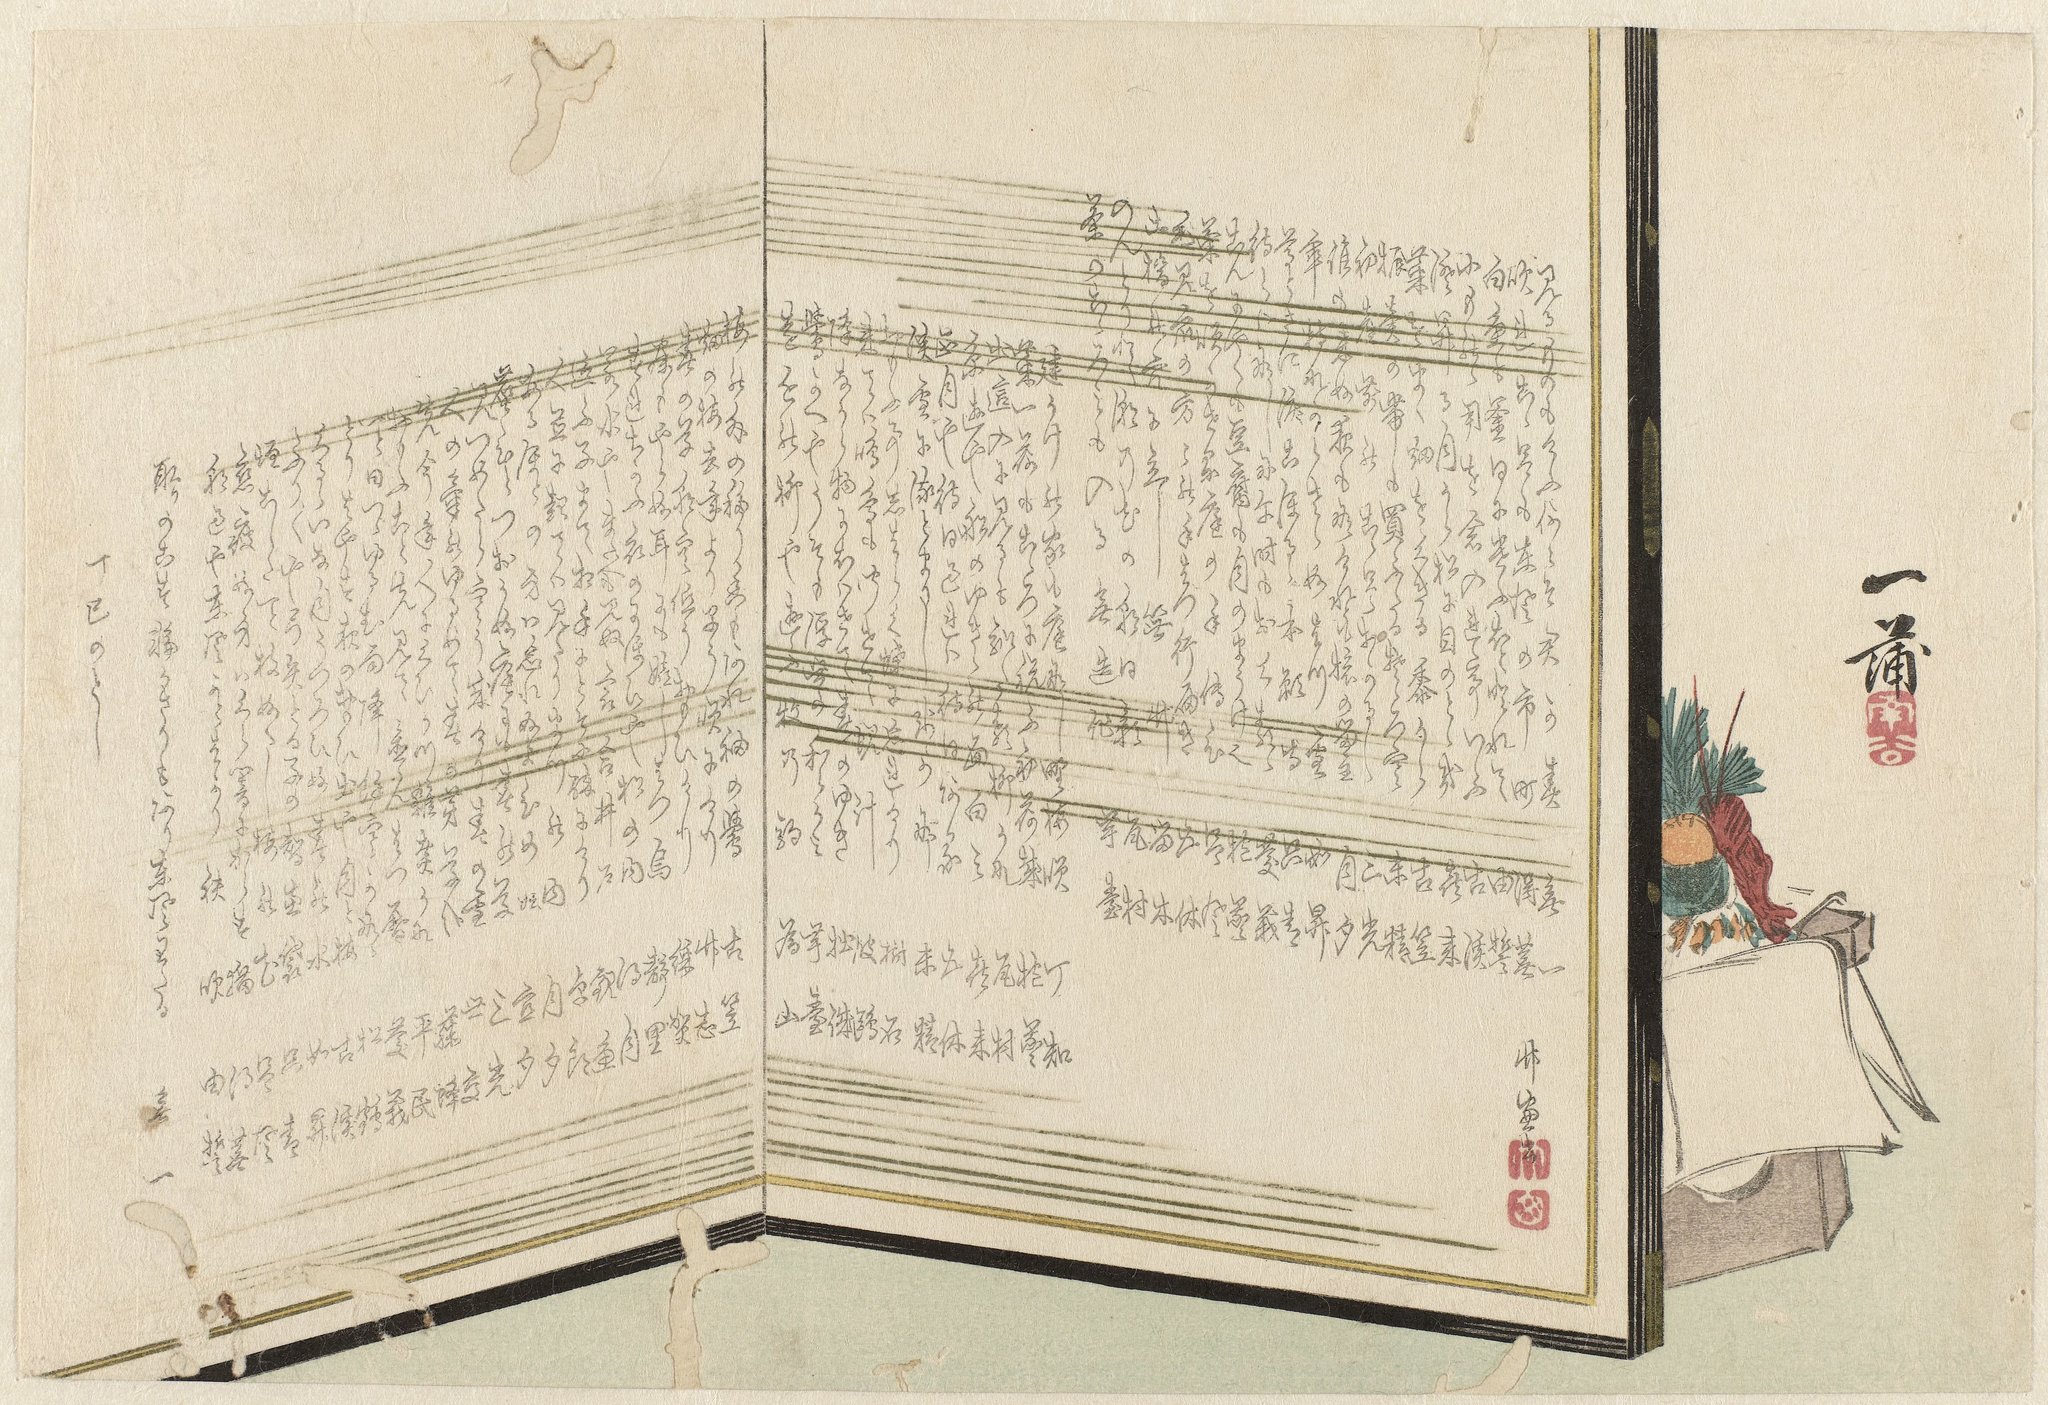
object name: print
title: Kamerscherm met gedichten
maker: mori ippô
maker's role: draughtsman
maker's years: 1798-1871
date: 1857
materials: paper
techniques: woodcut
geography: japan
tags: sacrifice ~ non-christian religions, oriental ideographic script (chinese, korean, japanese)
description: Een surimono is een luxe uitgevoerde prent waarop beeld met één of meerdere gedichten gecombineerd is. Bij het drukken van een surimono werd vaak gebruik gemaakt van dikker papier, blinddruk en metaal pigmenten, zoals koper- en zilverpoeder. De prenten werden vaak in opdracht van dichters gemaakt en als exclusief geschenk aan vrienden en relaties gegeven.